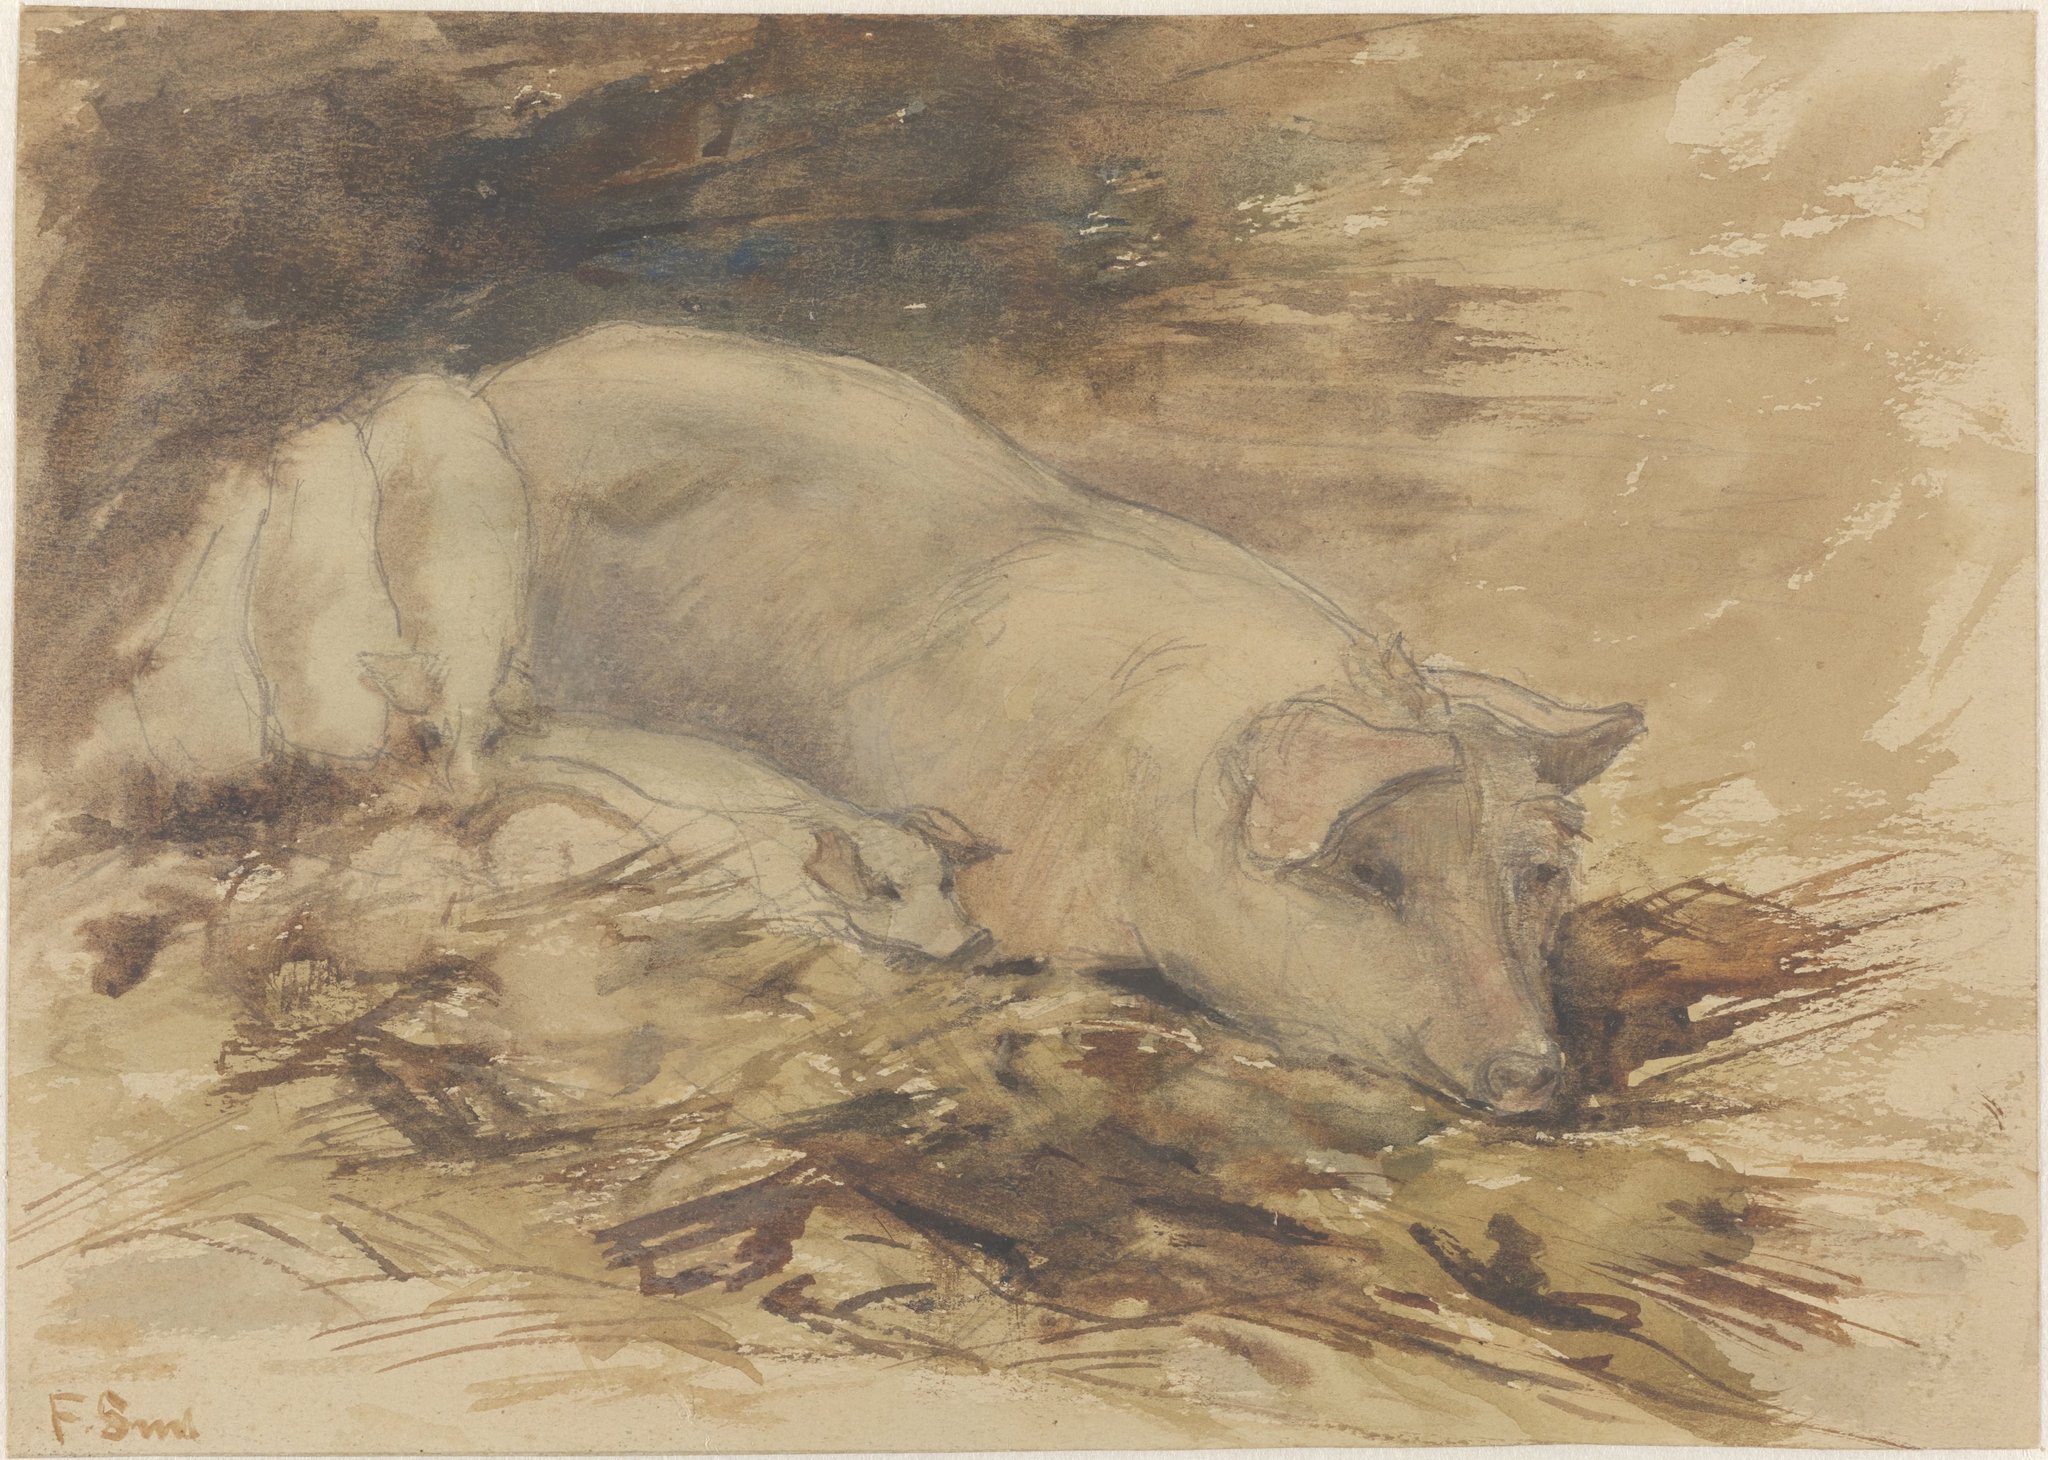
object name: watercolor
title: Zeug met biggen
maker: frans smissaert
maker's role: draughtsman, print maker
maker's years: 1862-1944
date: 1872-1944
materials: paper, pencil, watercolor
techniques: brush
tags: pig